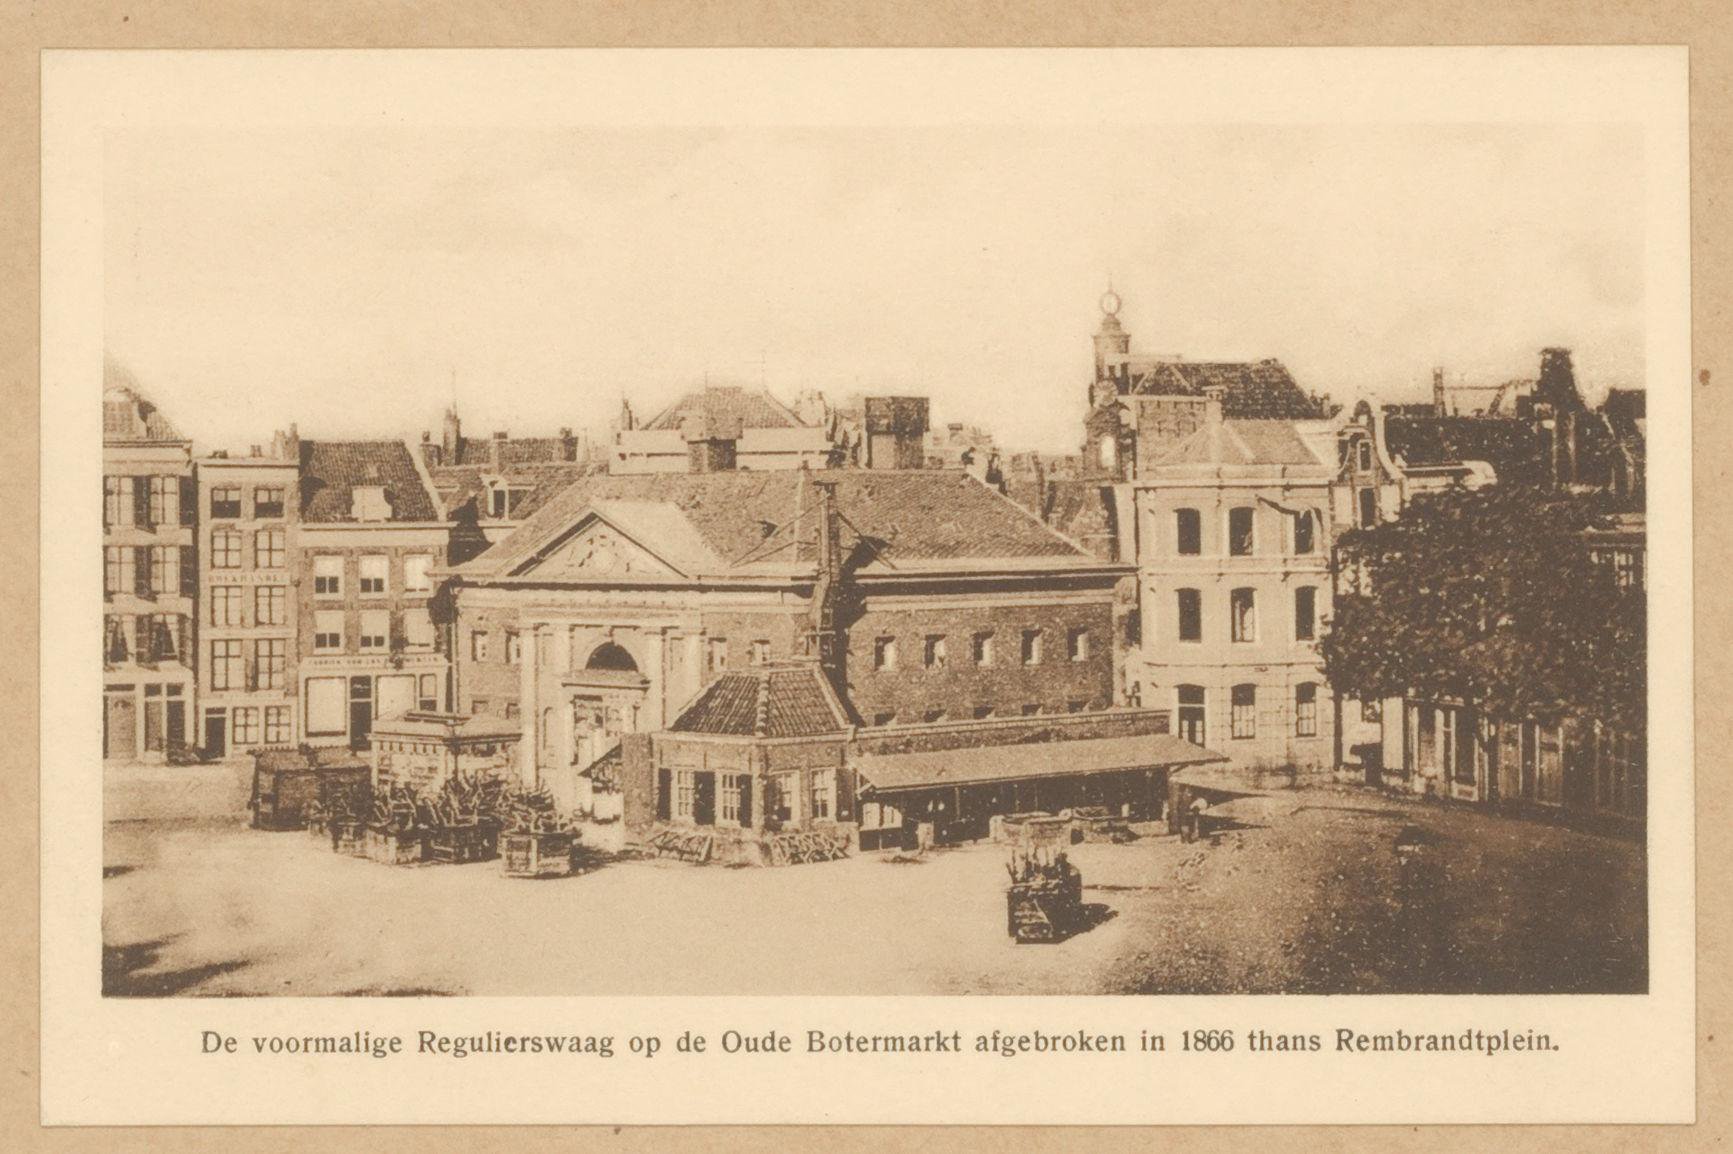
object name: photomechanical print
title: Gezicht op de Boterwaag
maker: Anonymous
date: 1905-1930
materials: cardboard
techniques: photograph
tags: square, place, circus, etc., city-view in general; 'veduta', weigh-house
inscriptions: collector's mark: ‘12-’ Lugt 1641b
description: Onderwerpsrubriek binnen de Atlas Amsterdam: Rembrandtplein (Botermarkt), Roeterseiland.